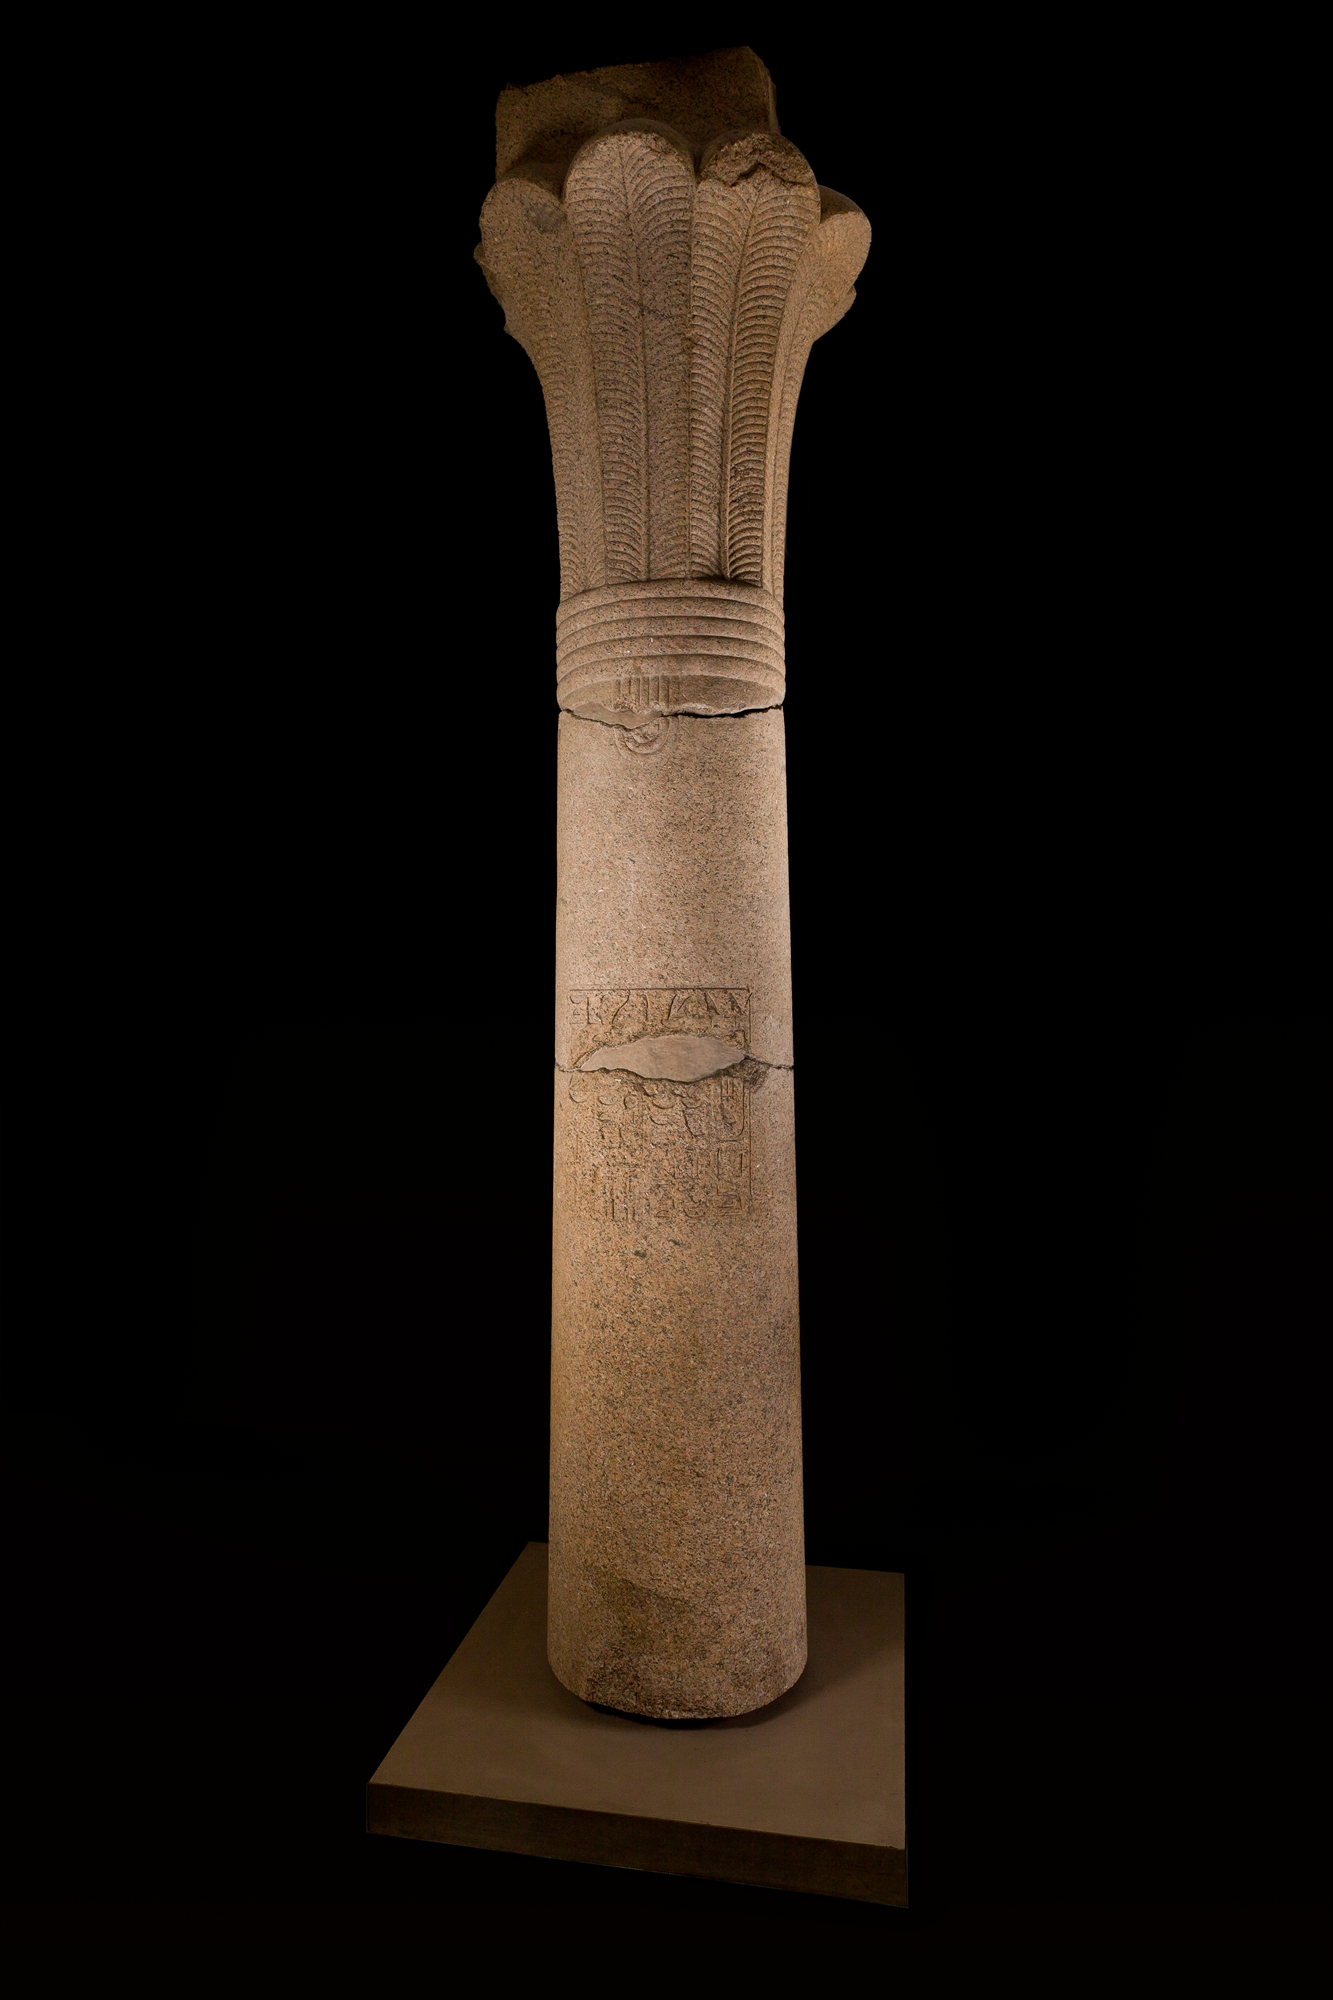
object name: column, sahure, palm capital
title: Palm Column of Sahure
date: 2458-2446 BCE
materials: granite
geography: egypt